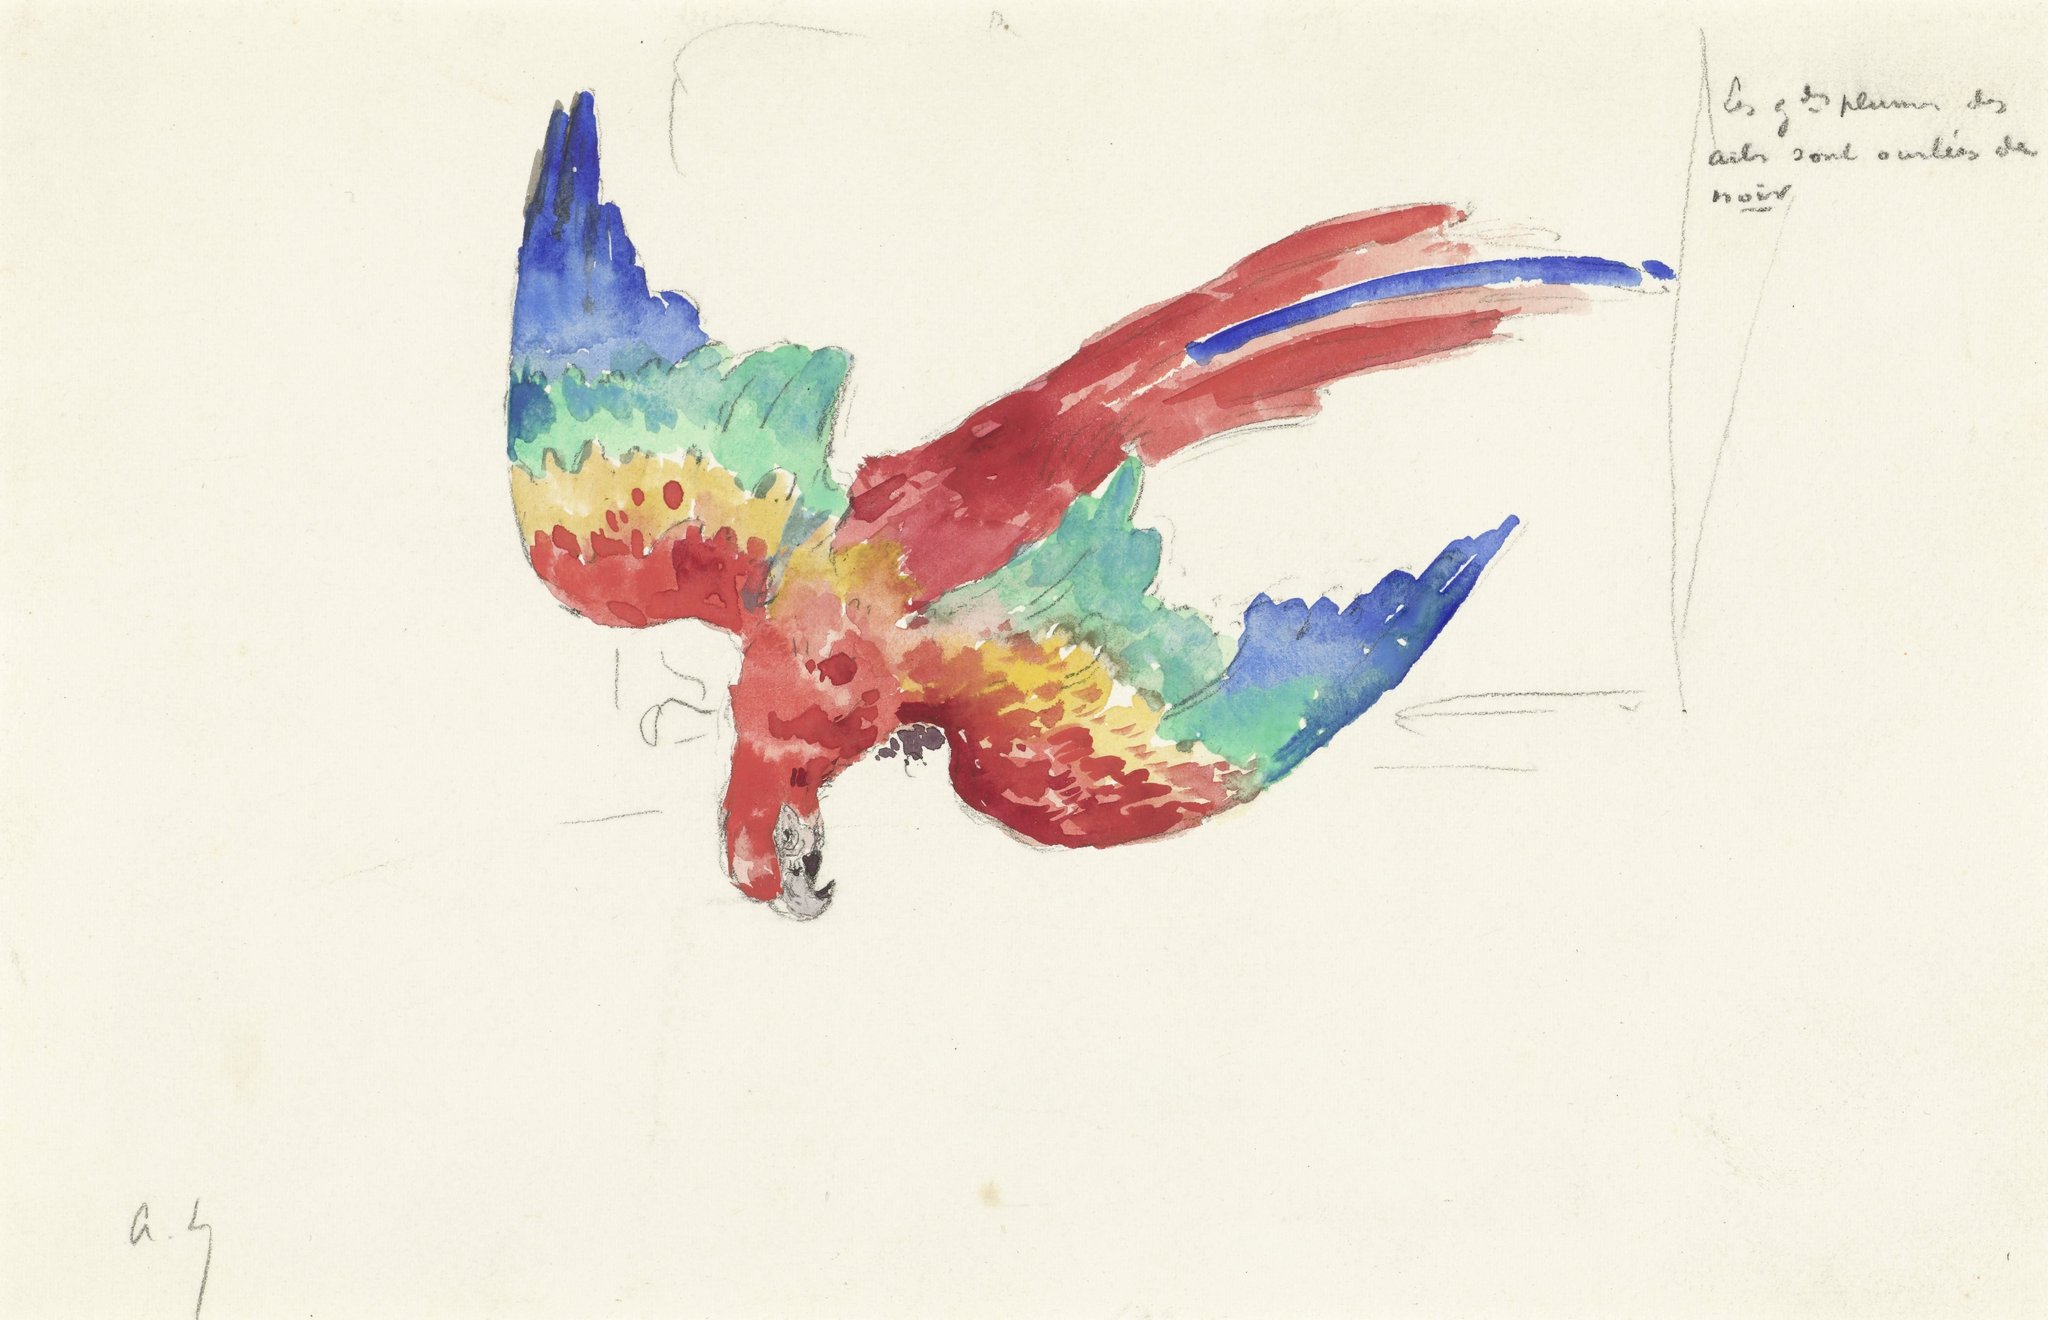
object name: drawing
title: Papegaai, naar beneden ziende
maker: alexandre lunois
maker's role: draughtsman, print maker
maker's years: 1863-1916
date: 1873-1916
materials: chalk, paper, watercolor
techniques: brush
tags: ornamental birds: parrot